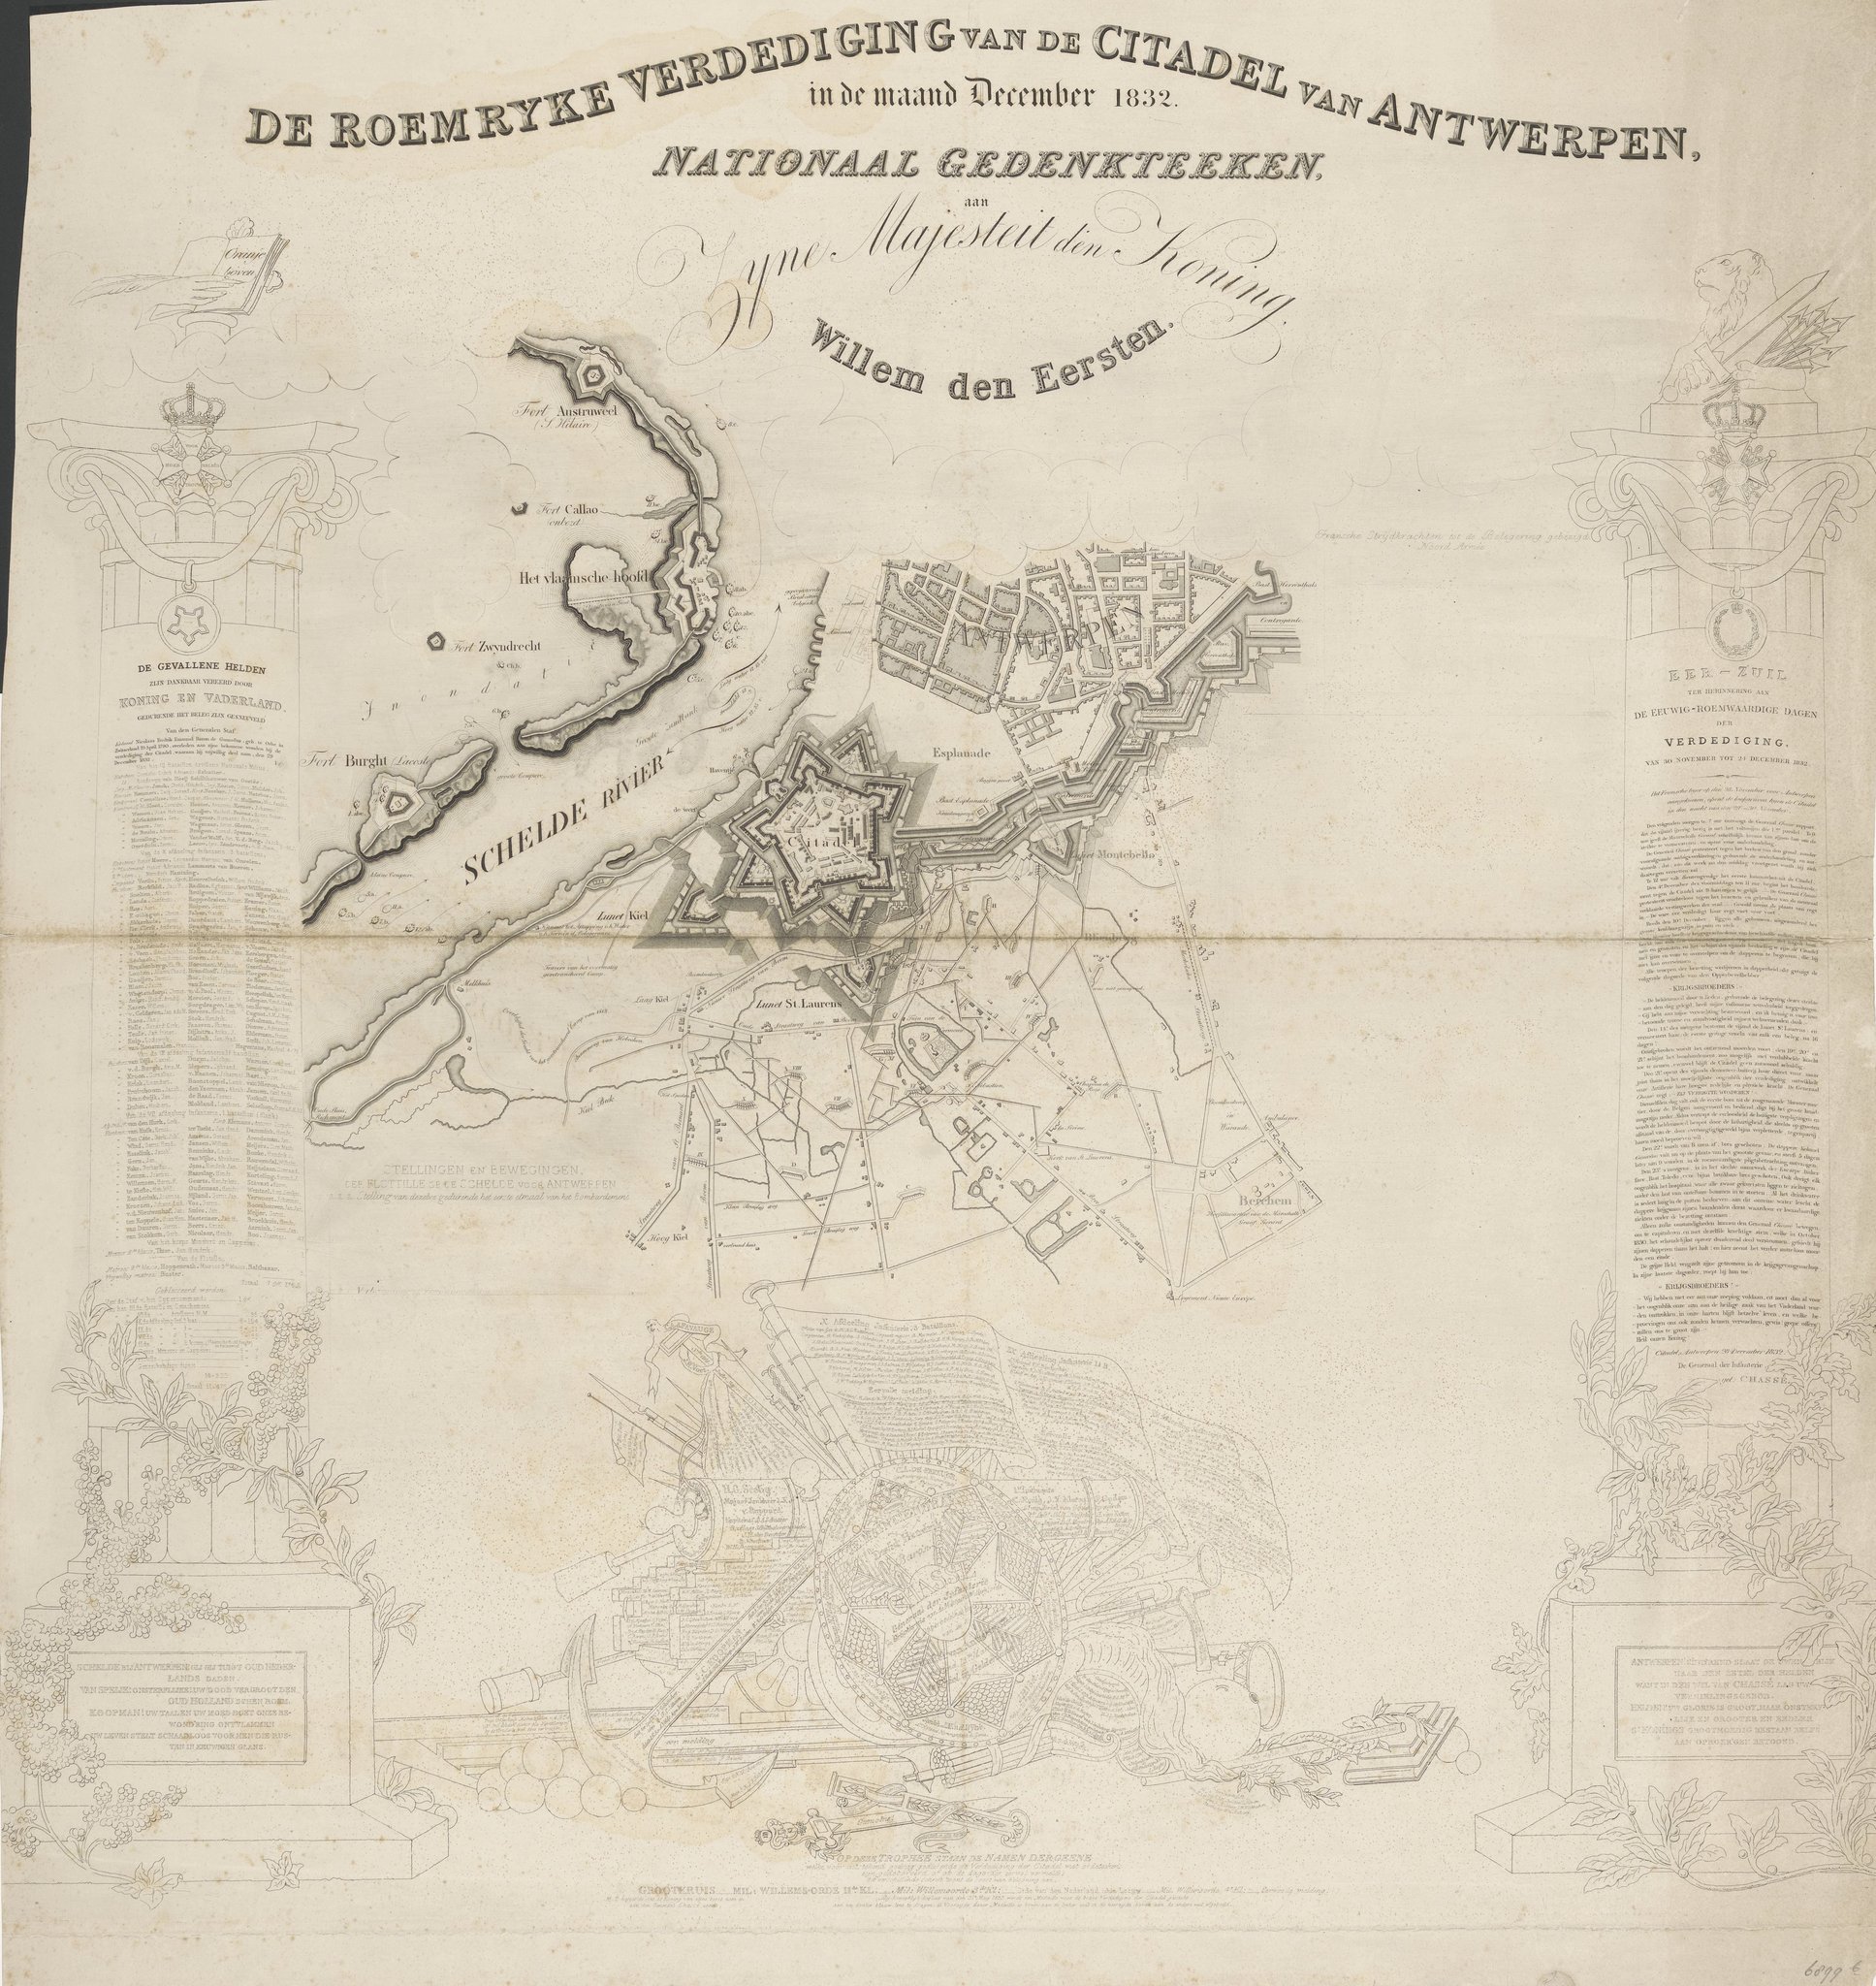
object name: print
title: De Roemryke Verdediging van de Citadel van Antwerpen, in de maand December 1832. Nationaal Gedenkteeken, aan Zyne Majesteit den Koning, Willem den Eersten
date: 1834-1835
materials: paper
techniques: etching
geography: london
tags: david hendrik baron chassé, berlin, william i of the netherlands, siege, position war, permanent fortifications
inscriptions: collector's mark: Lugt 2228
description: Allegorische voorstelling met centraal een plattegrond van de Citadel van Antwerpen en de Franse belegeringswerken. Links een zuil met de namen van de Nederlandse militairen gesneuveld bij het beleg. Rechts een zuil met een verslag van het beleg door generaal Chassé. Onderaan een kanon, schild, vlaggen en andere attributen van de oorlog waarop de namen staan van de gedecoreerden.